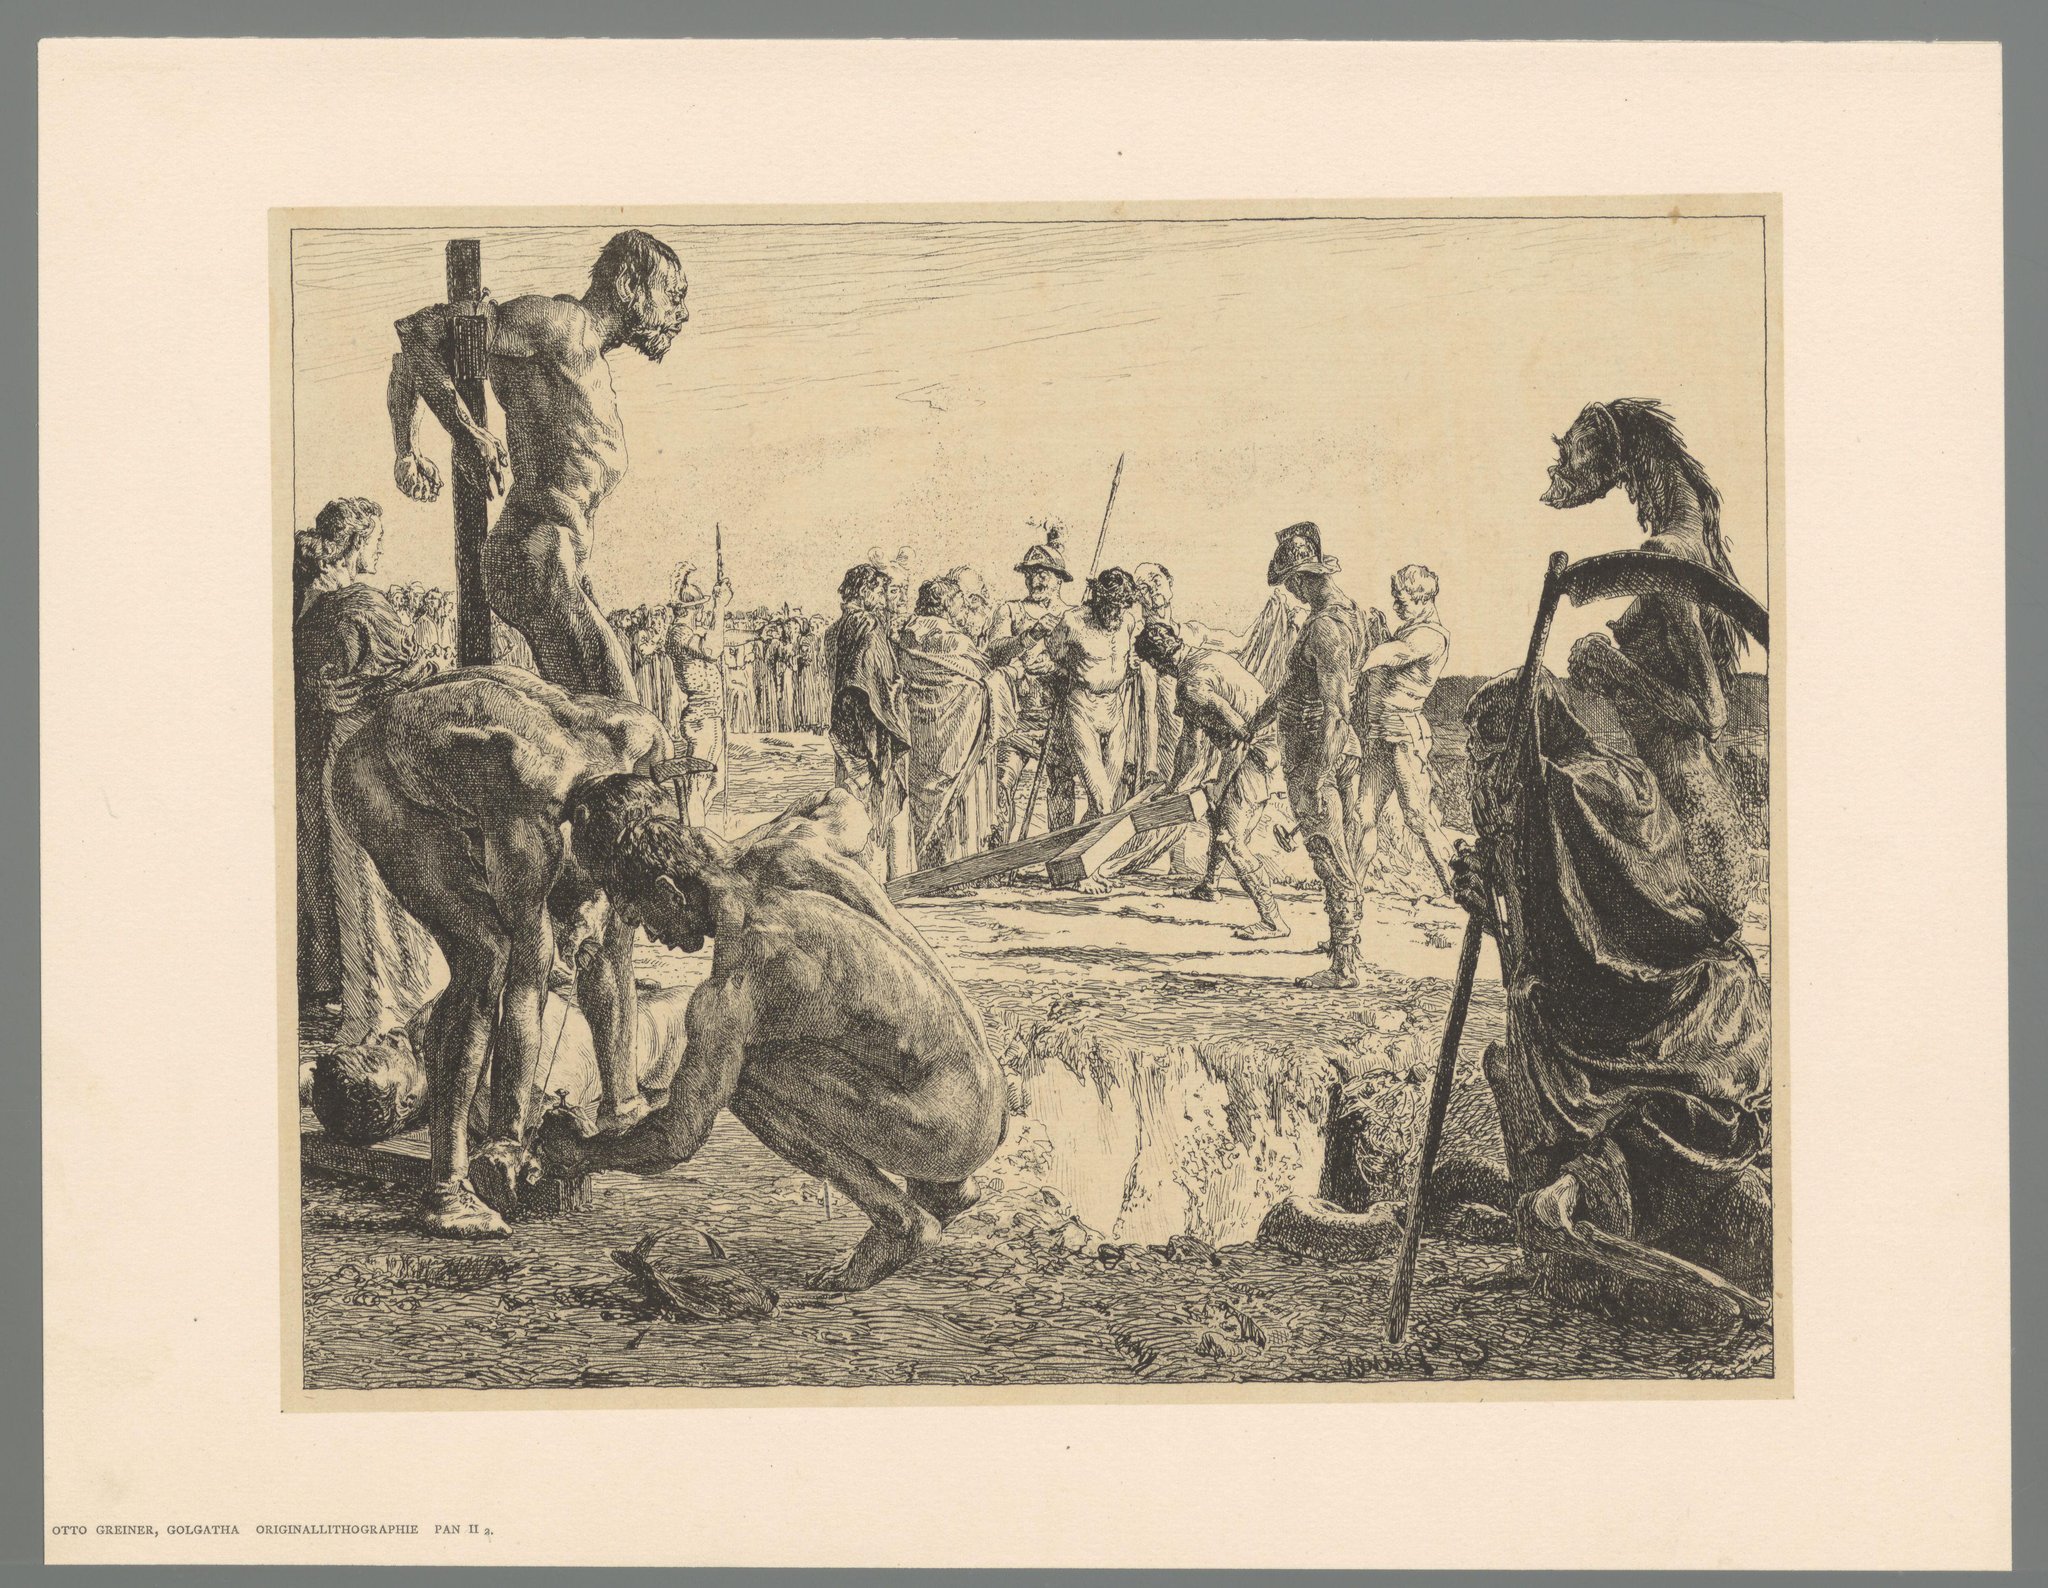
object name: print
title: Oprichting van de drie kruizen op Golgotha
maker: otto greiner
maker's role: print maker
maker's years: 1869-1916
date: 1890-1899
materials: paper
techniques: lithograph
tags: the erection of the cross: raising of the cross (without christ), death as man, christ is led to golgotha, the cross is carried by others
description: De figuur rechts is Magere Hein met zeis; hij symboliseert de dood. Linksonder: (...) PAN II 2.